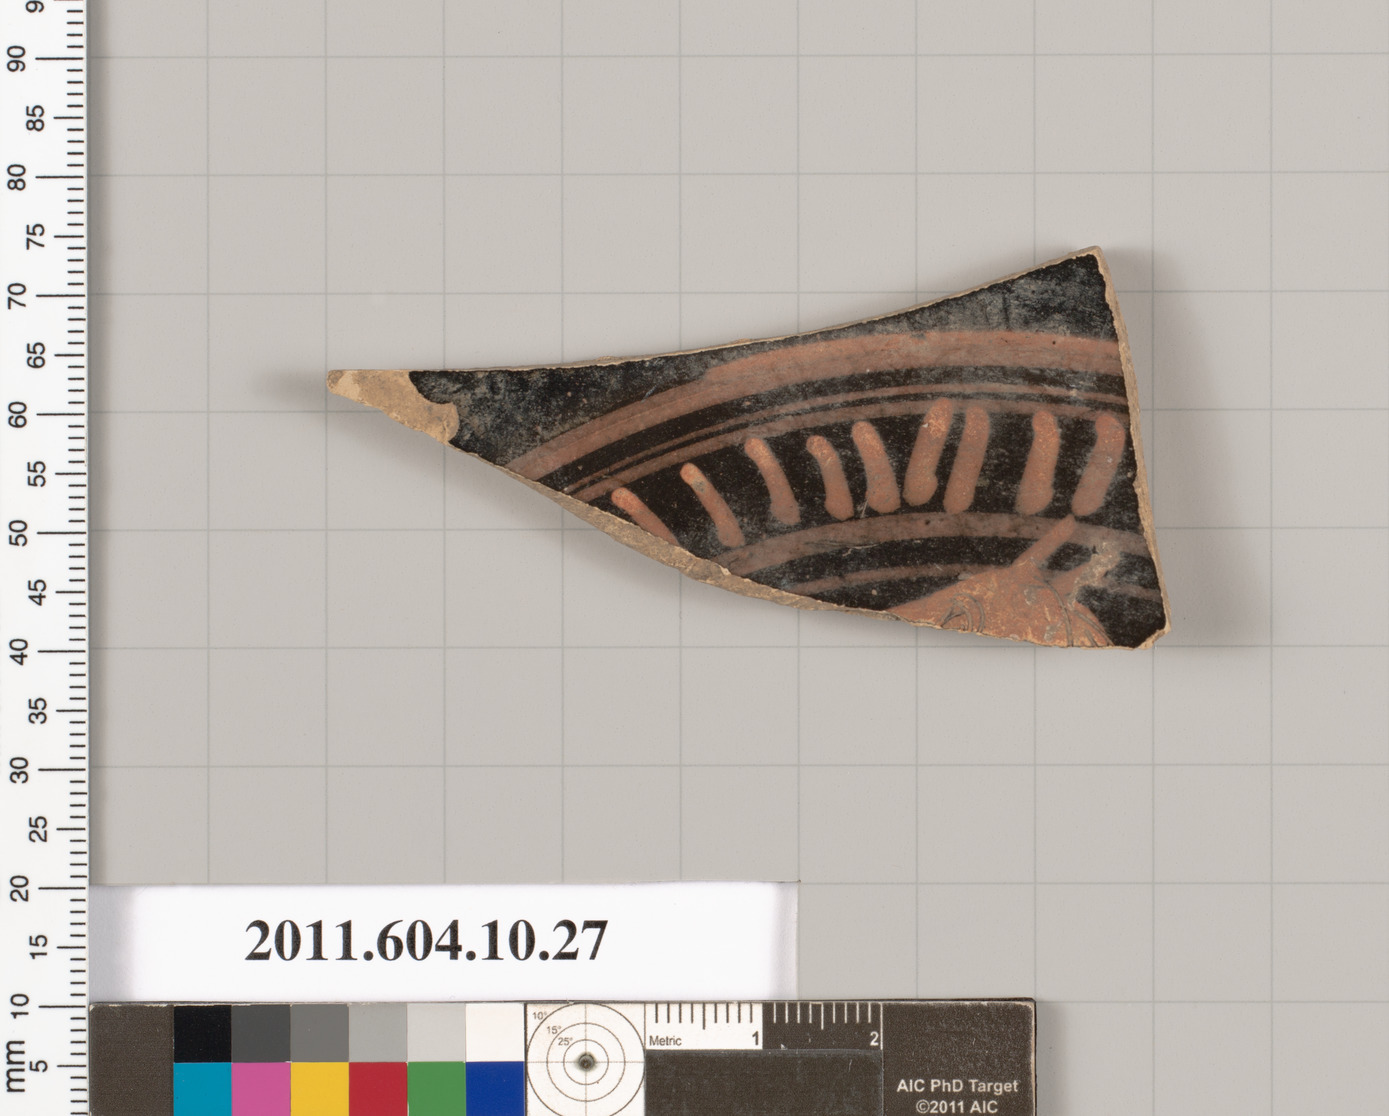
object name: kylix fragment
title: Terracotta fragment of a kylix (drinking cup)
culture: etruscan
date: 434-368 BCE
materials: terracotta